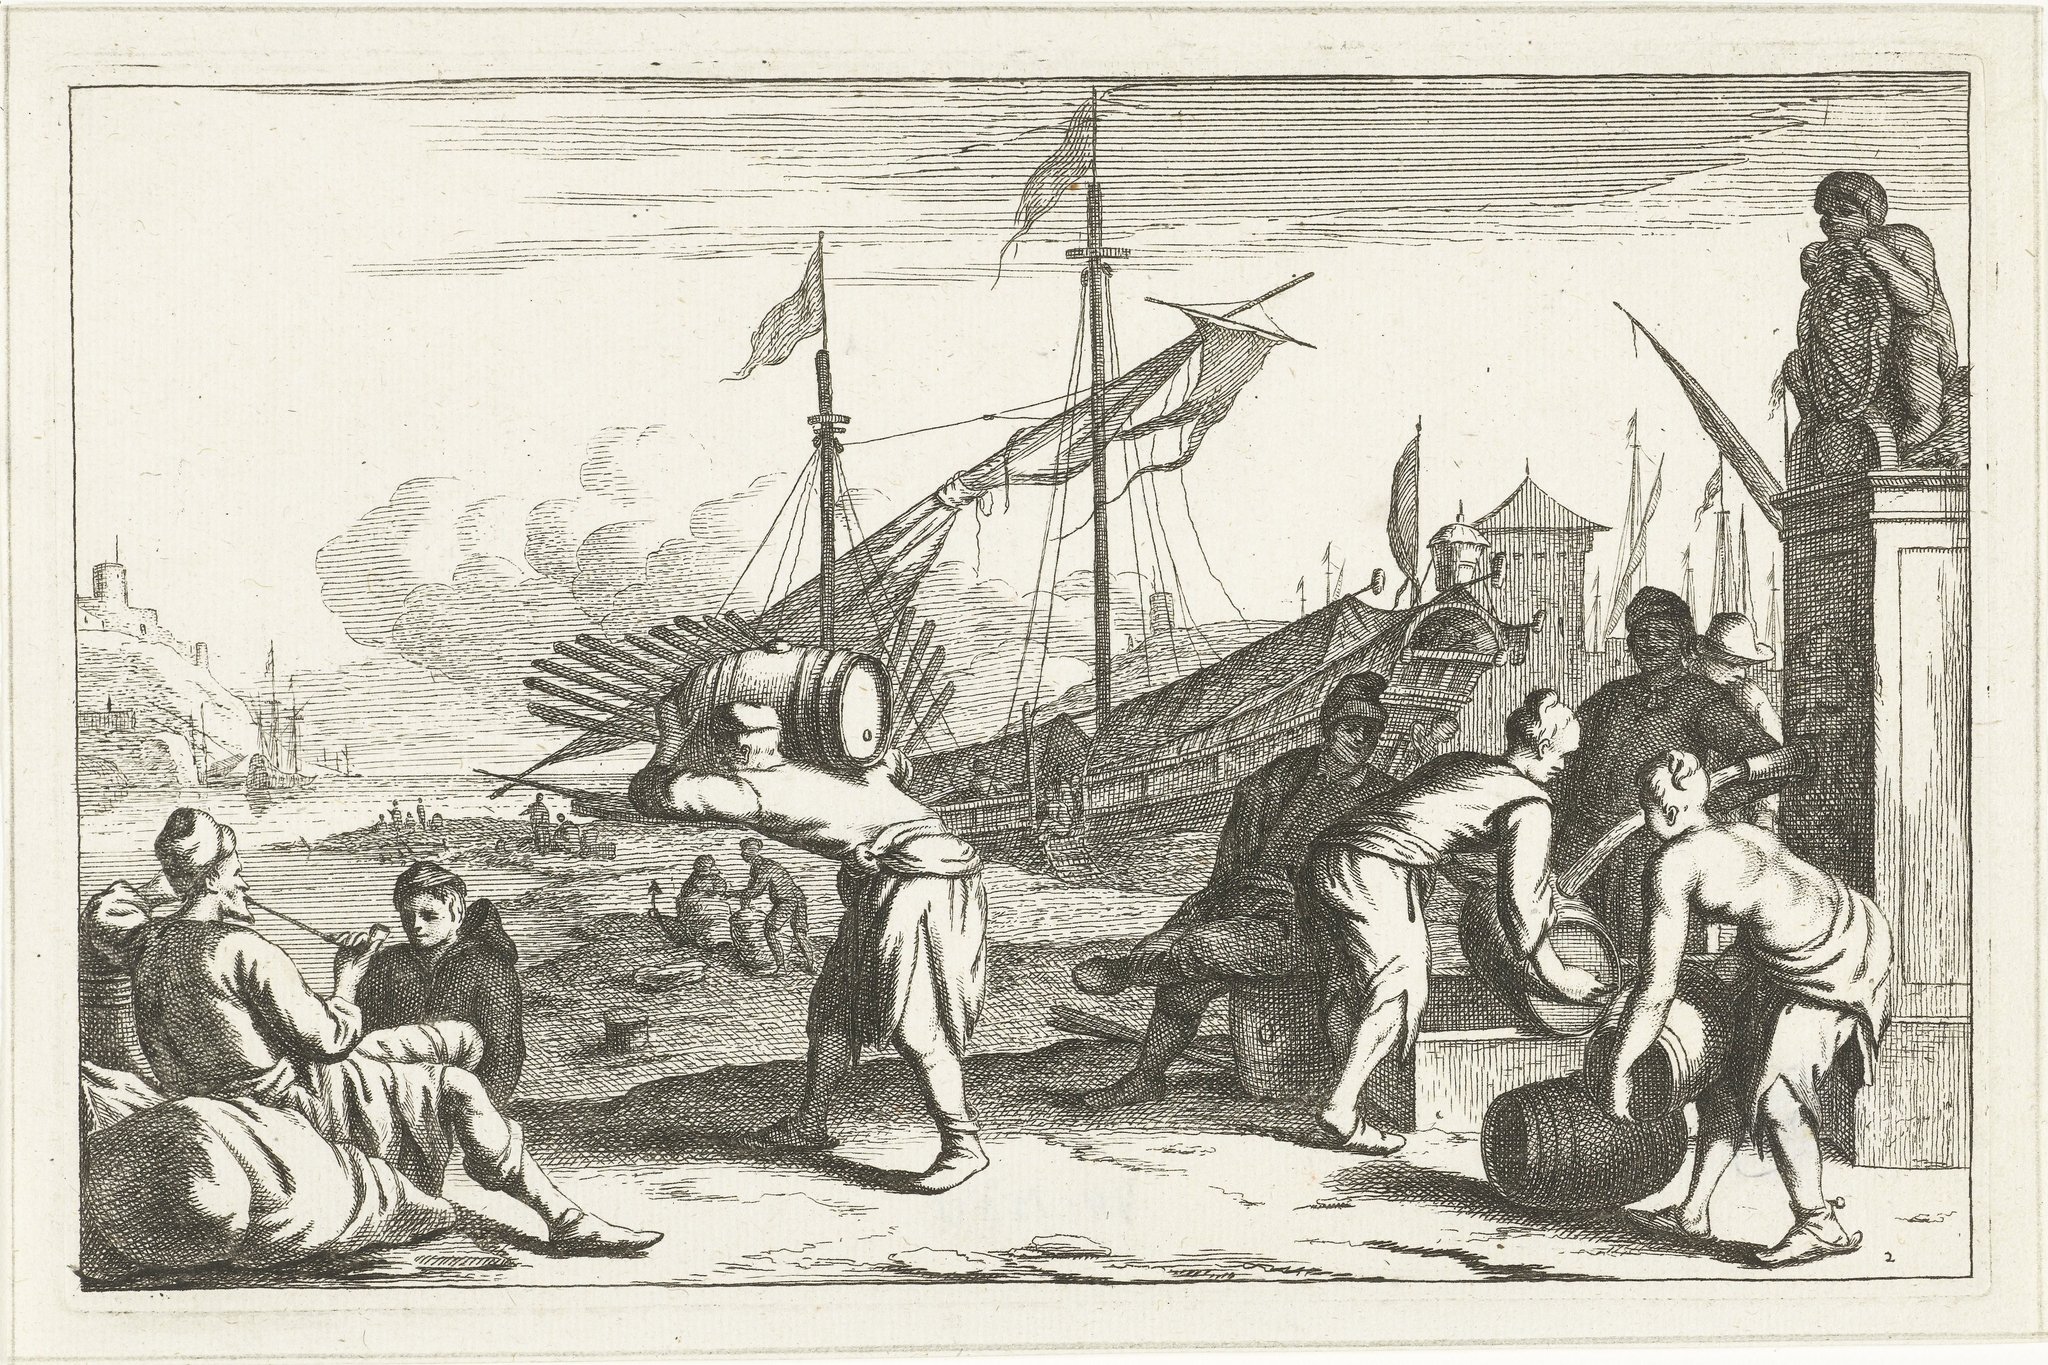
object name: print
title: Aliqui Portus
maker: johannes gronsveld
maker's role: draughtsman, painter, print maker, publisher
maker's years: 1658-1728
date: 1679-1728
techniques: engraving, etching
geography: amsterdam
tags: harbour (+ four persons or more ~ traffic and transport)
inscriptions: collector's mark: ‘b, twee onleesbare letters, l, en een langwerpig figuur’, collector's mark: Lugt 2228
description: Haven met op de voorgrond een koopman met een ton op zijn rug die naar het water loopt. Links een pijprokende man op de rug gezien. Rechts bij een fontein vult een vrouw een ton met water. Op de achtergrond een zeilschip en rechts een uitkijktoren van een fort. Tweede prent uit een serie van twaalf met Italiaanse havens.